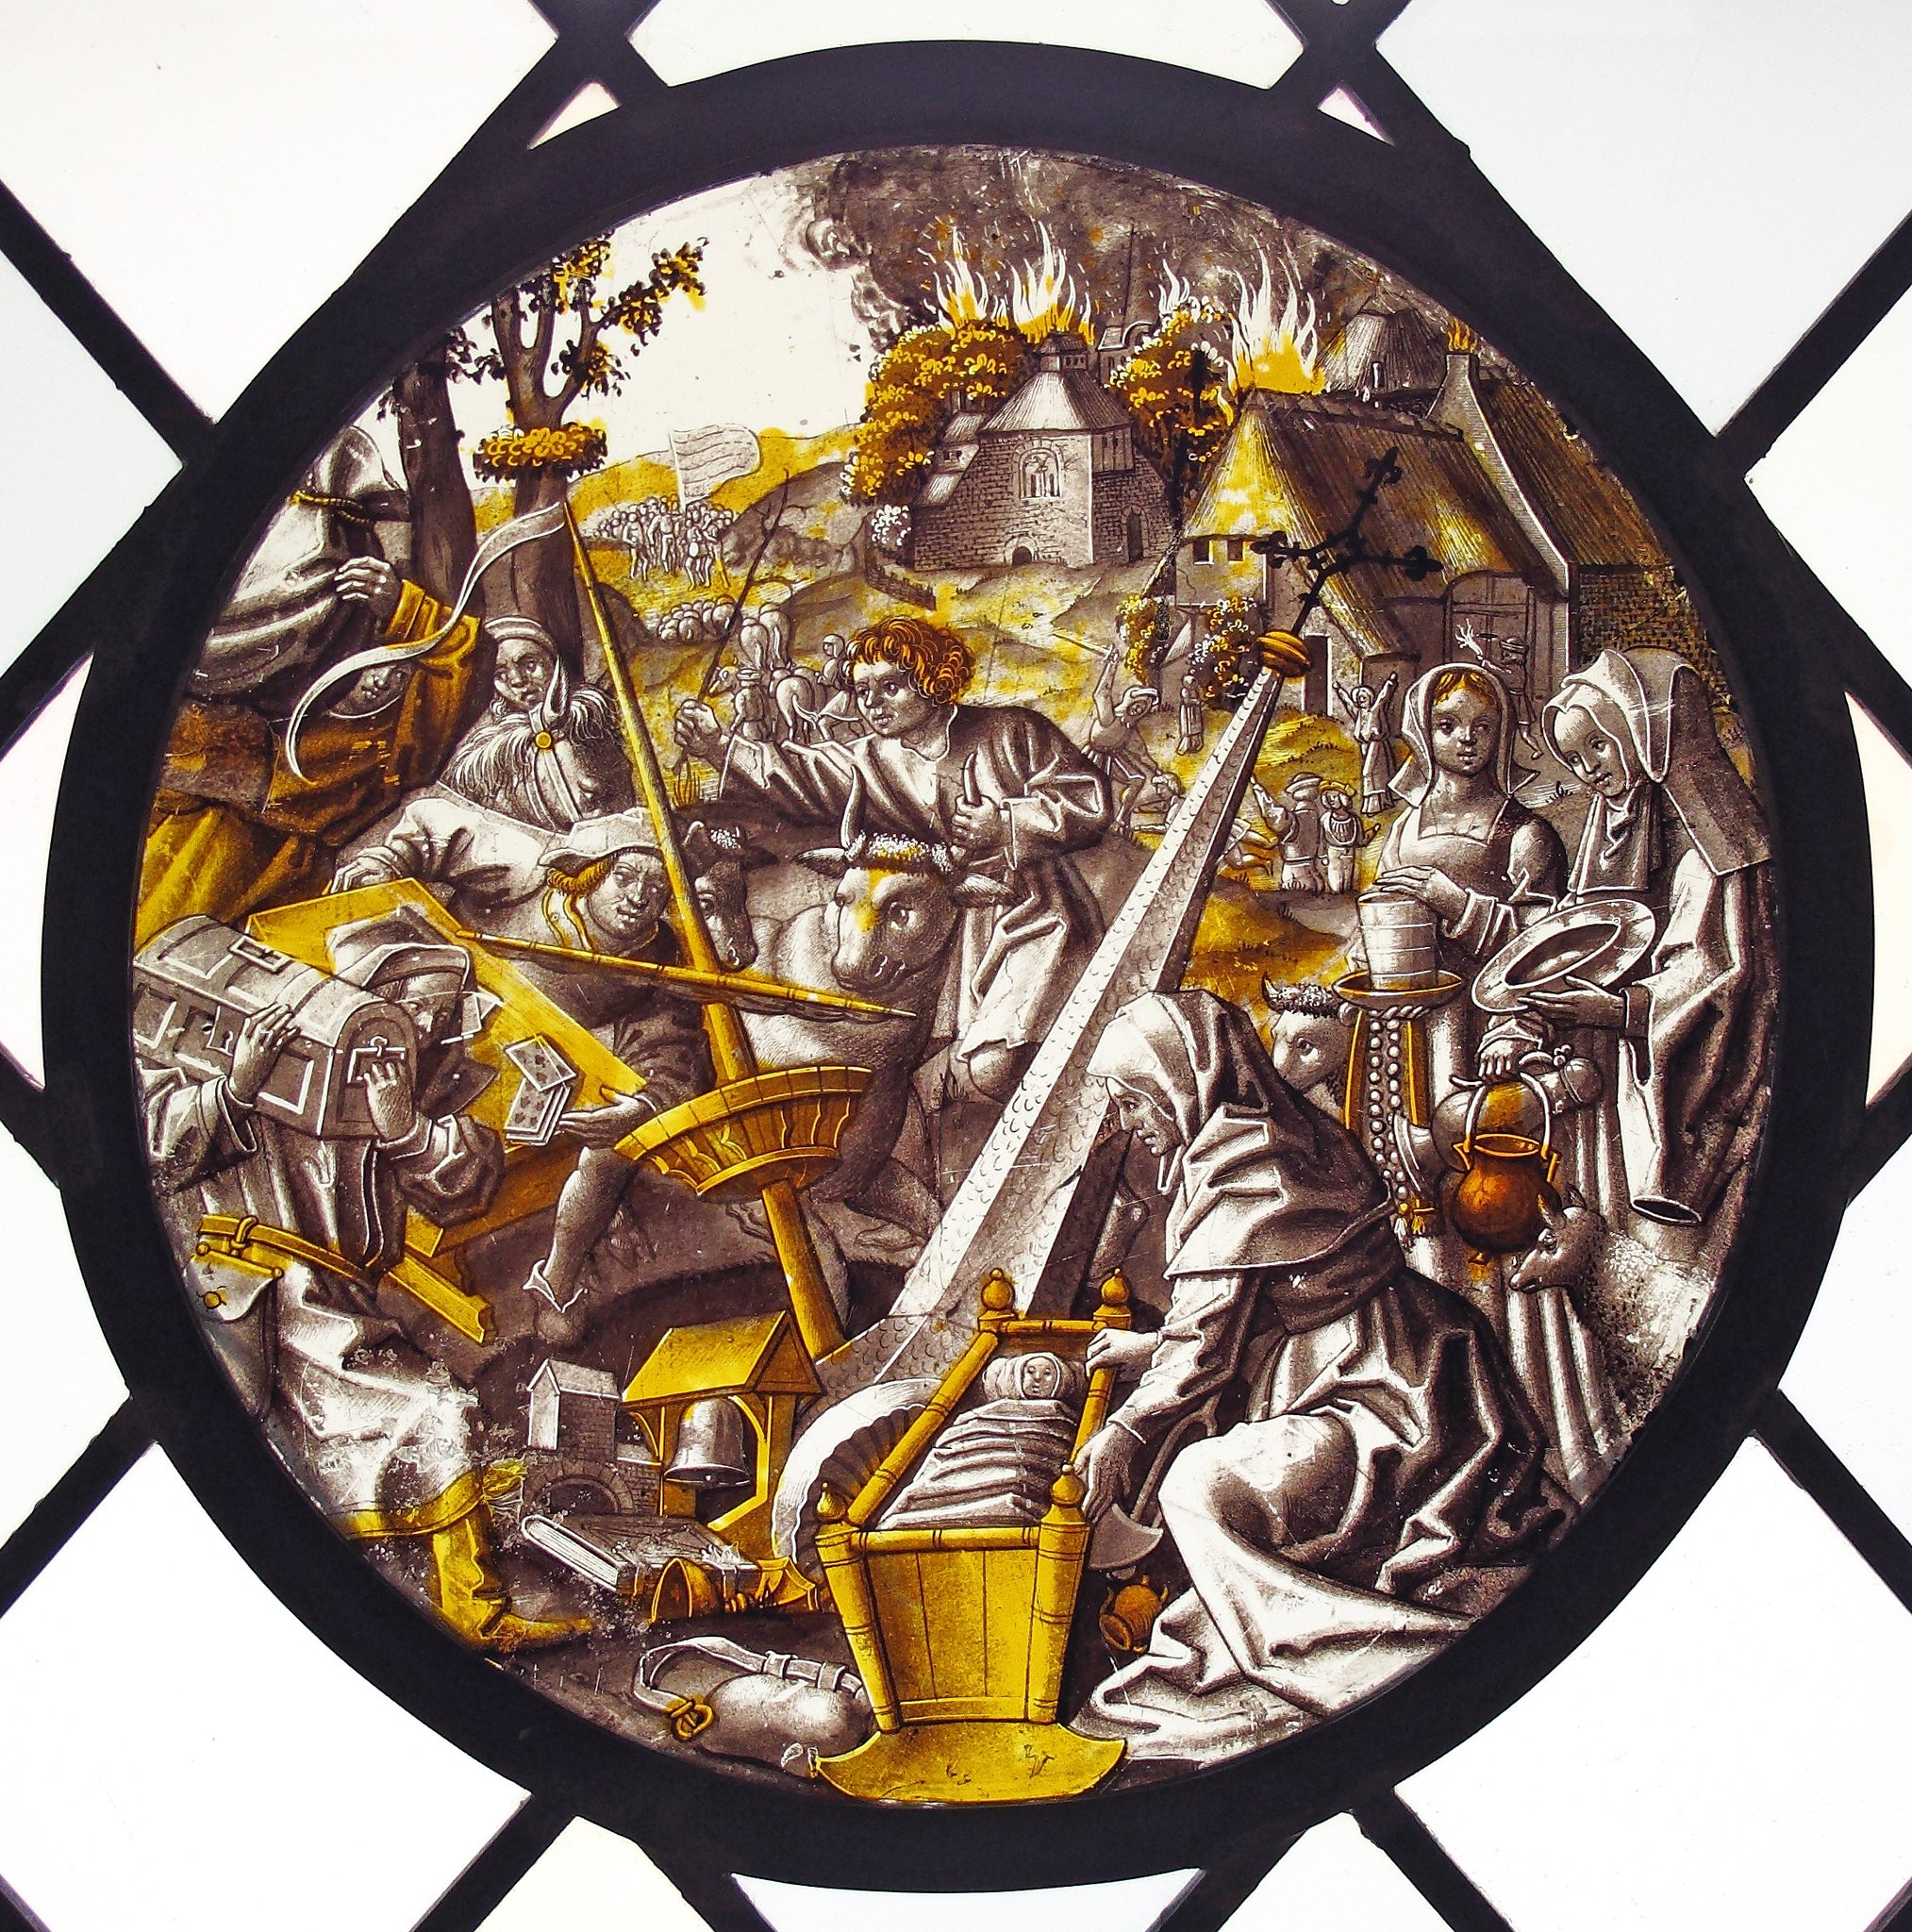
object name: roundel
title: Allegory of Rout and Pillage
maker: dirck vellert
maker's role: maker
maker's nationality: netherlandish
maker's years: 1475-1552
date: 1520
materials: glass, paint, pigment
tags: villages,infants,men,women,cows